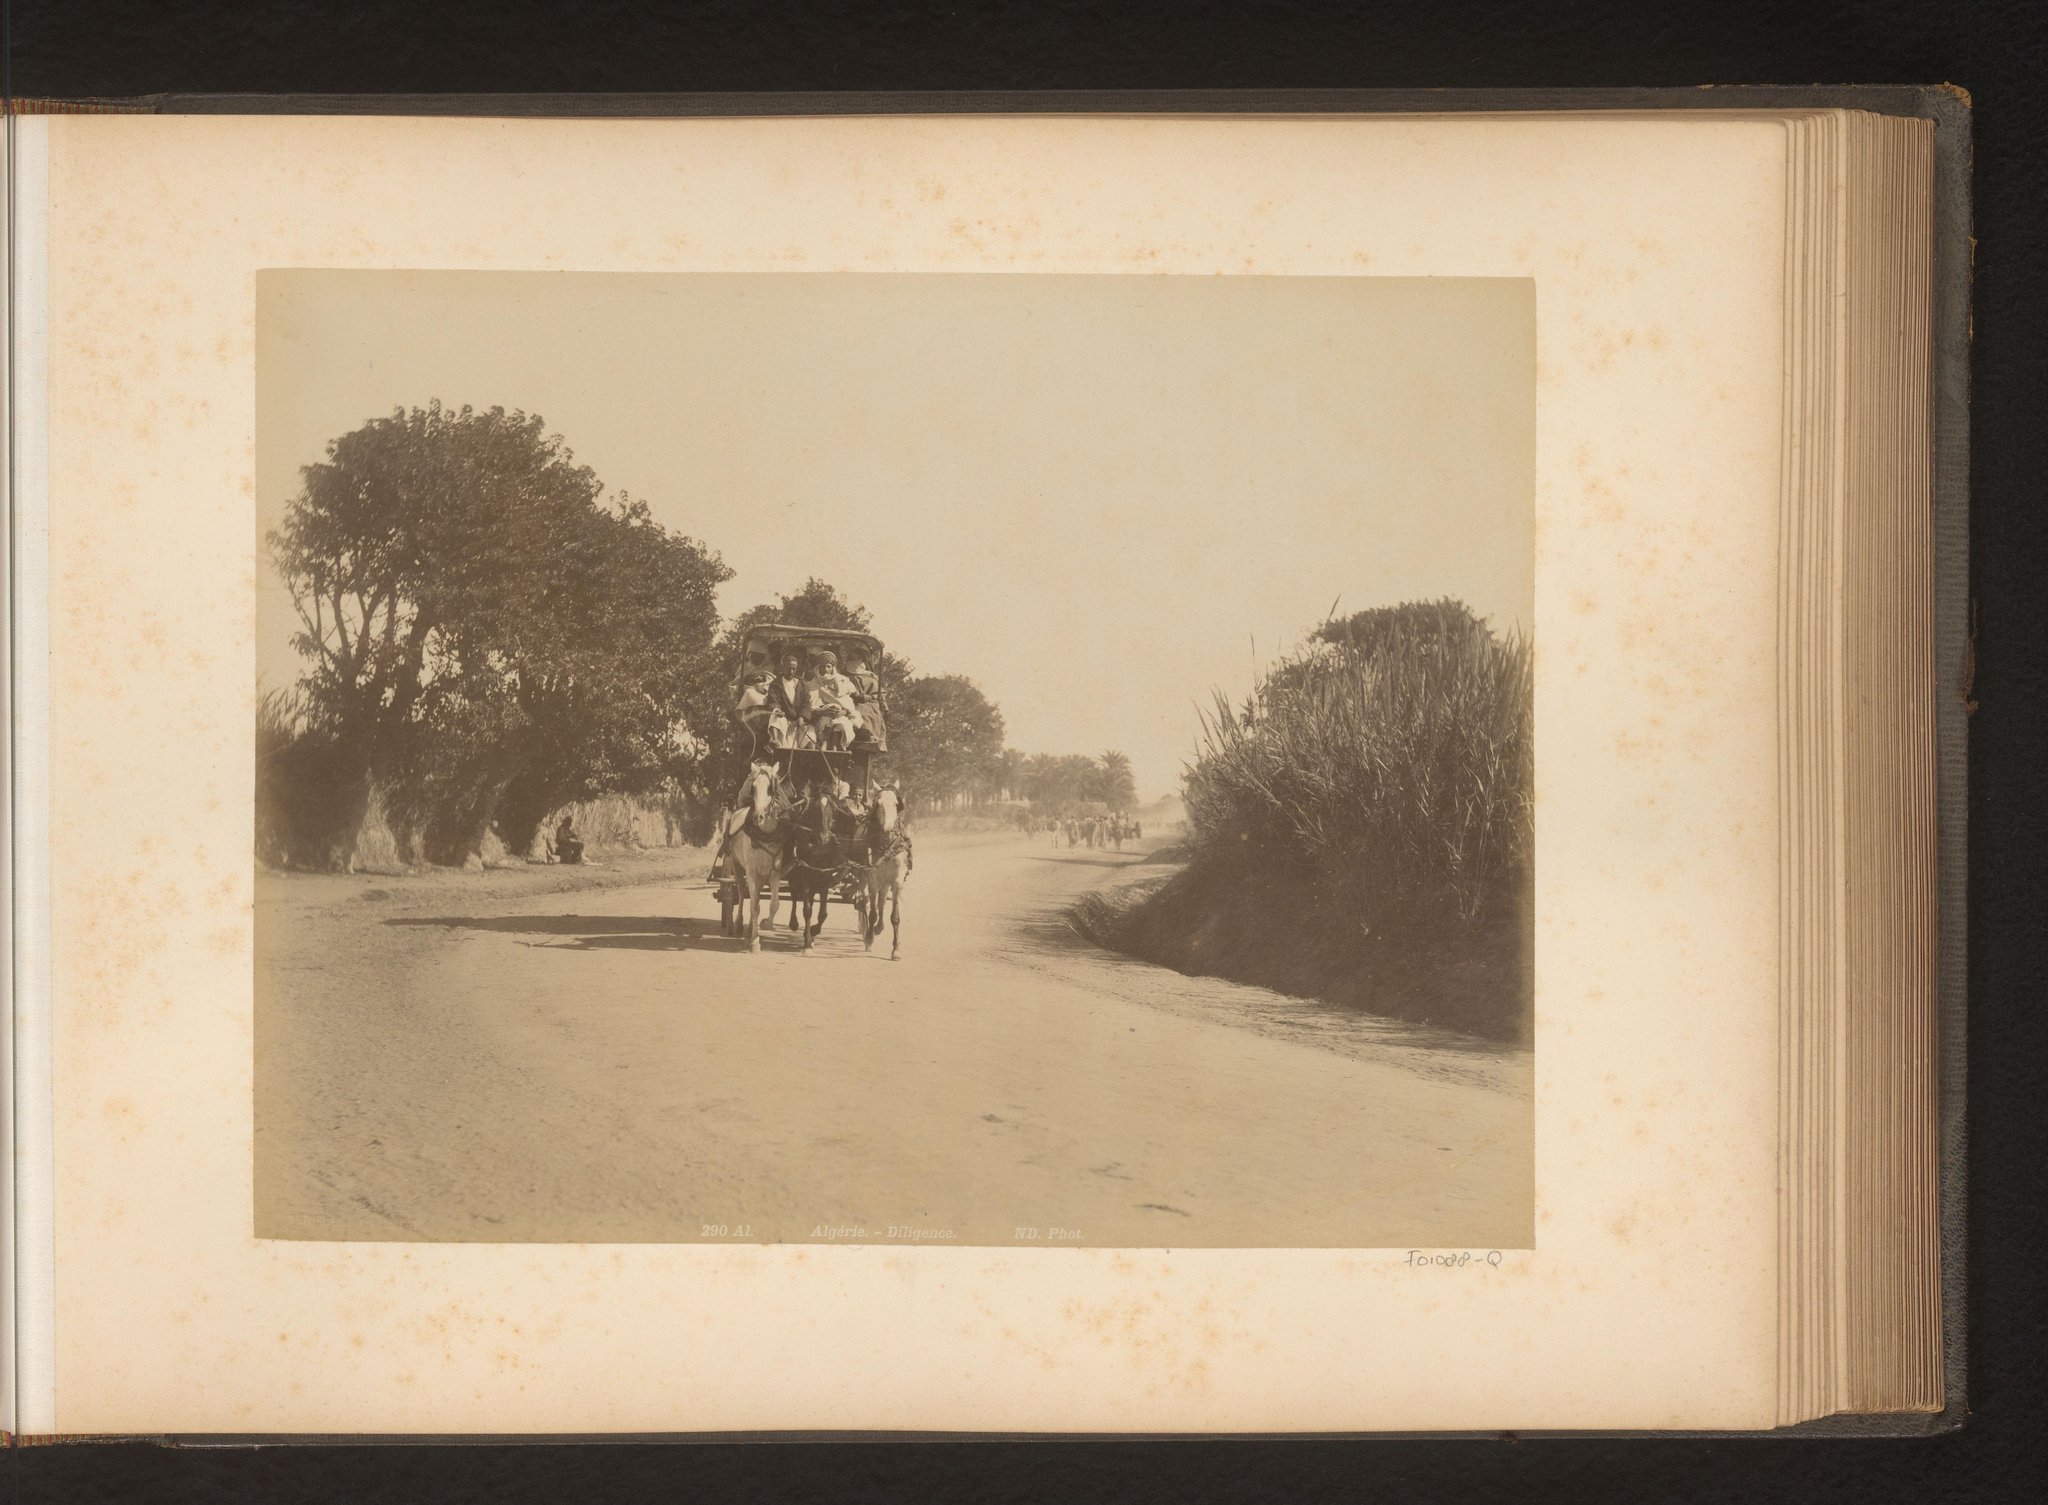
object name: photograph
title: Kar getrokken door paarden op een pad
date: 1880-1900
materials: photographic support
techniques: albumen print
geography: algiers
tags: animal traction, animal-drawn vehicle (carriage etc.), historical persons, road, path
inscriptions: number: ‘290 A1’